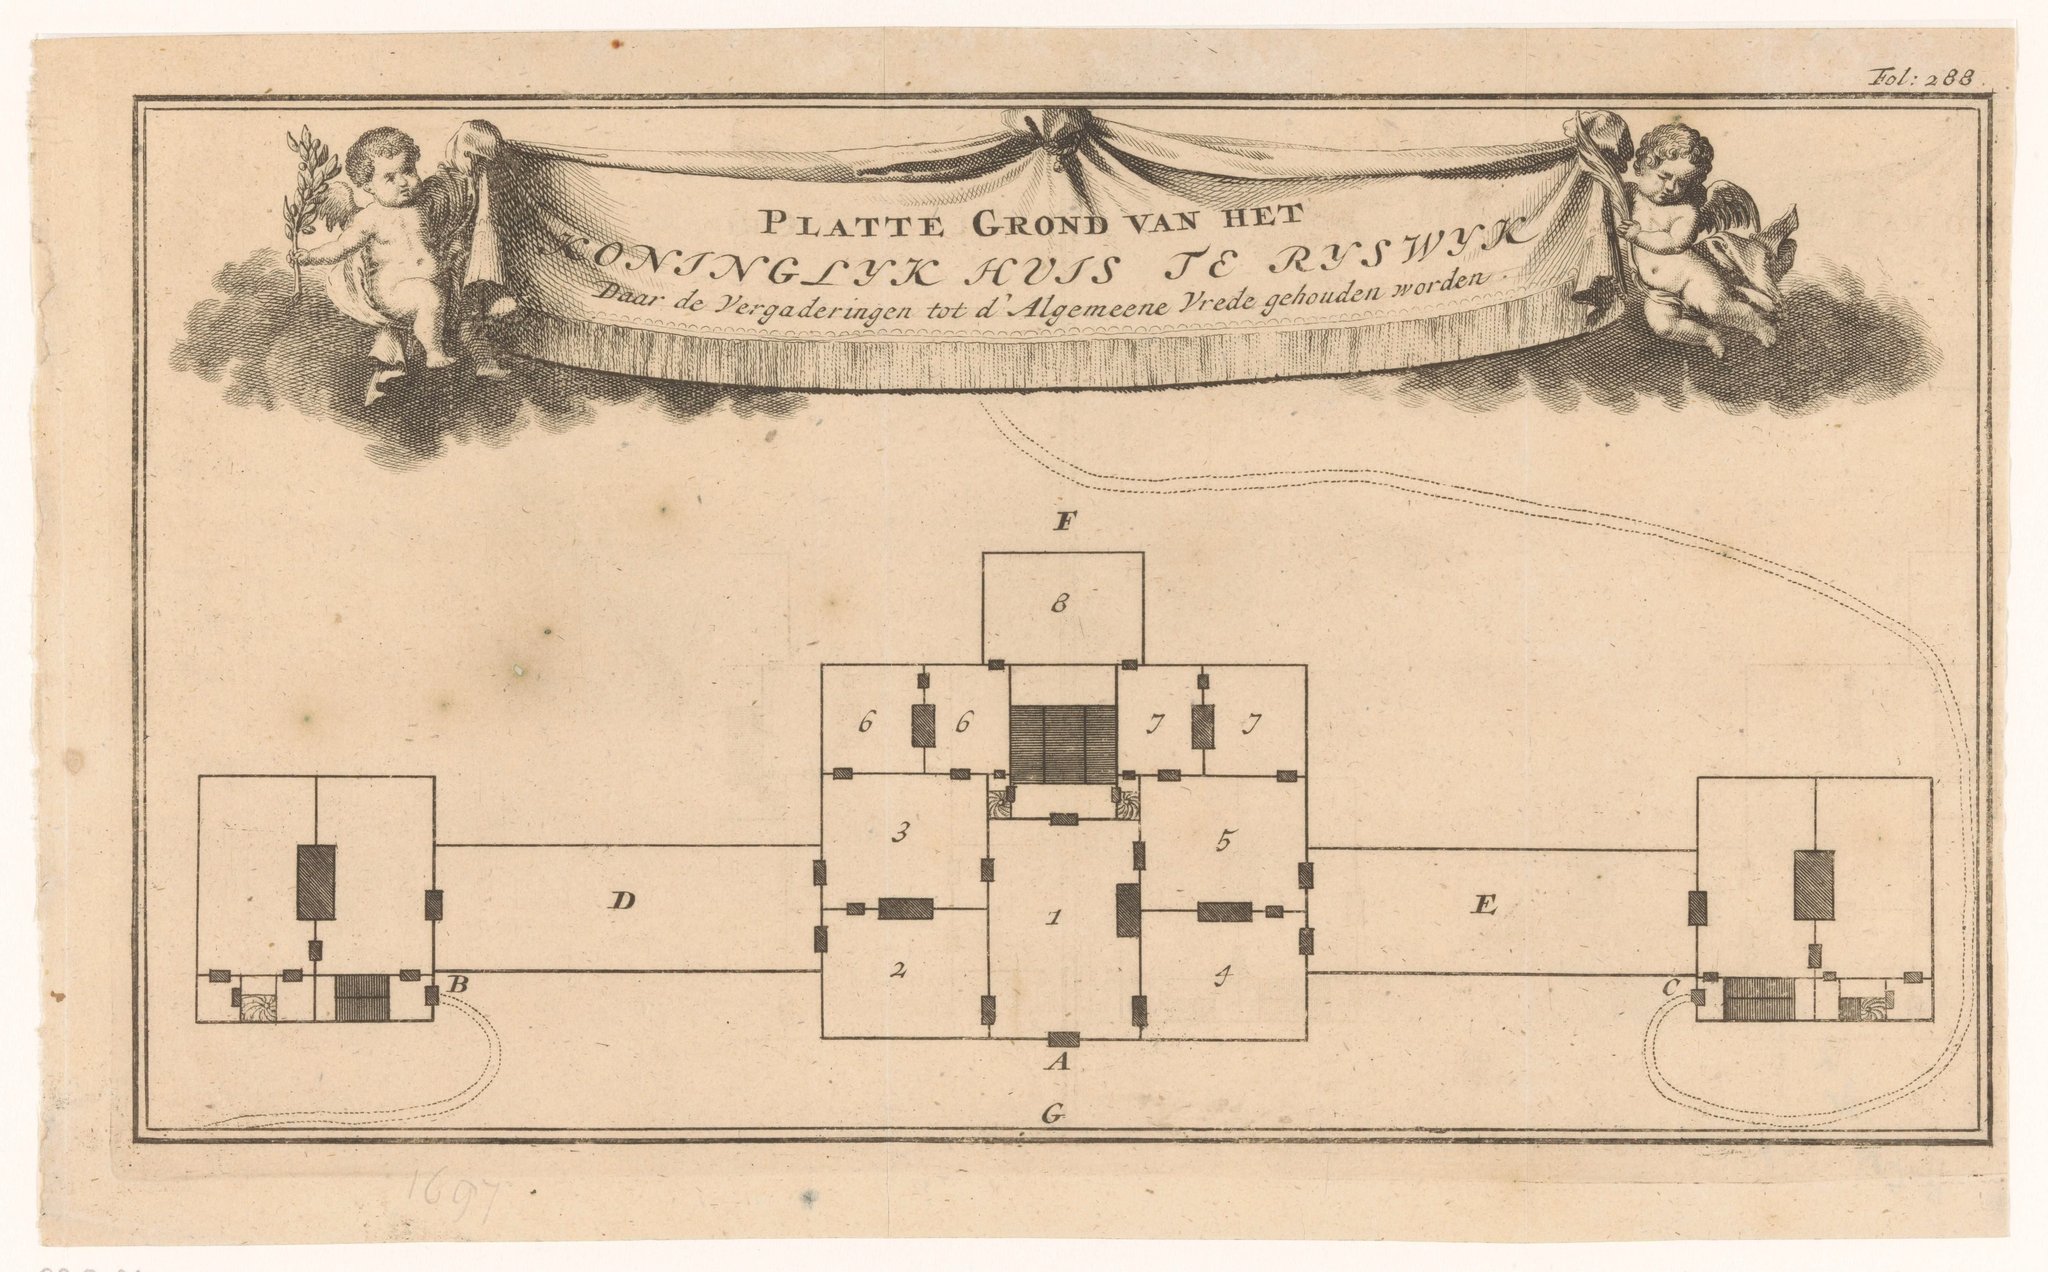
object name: print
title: Platte grond van het koninglyk huis te Ryswyk daar de vergaderingen tot d'Algemeene Vrede gehouden worden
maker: Anonymous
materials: paper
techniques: engraving, etching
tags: palace, plan ~ architecture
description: Plattegrond van het Huis ter Nieuburch in Rijswijk waar in 1697 de vredesbesprekingen werden gehouden. De titel op een doek opgehouden door twee putti, in de plattegrond de onderdelen aangeduid met cijfers en letters. Rechtsboven gemerkt: Fol: 288.